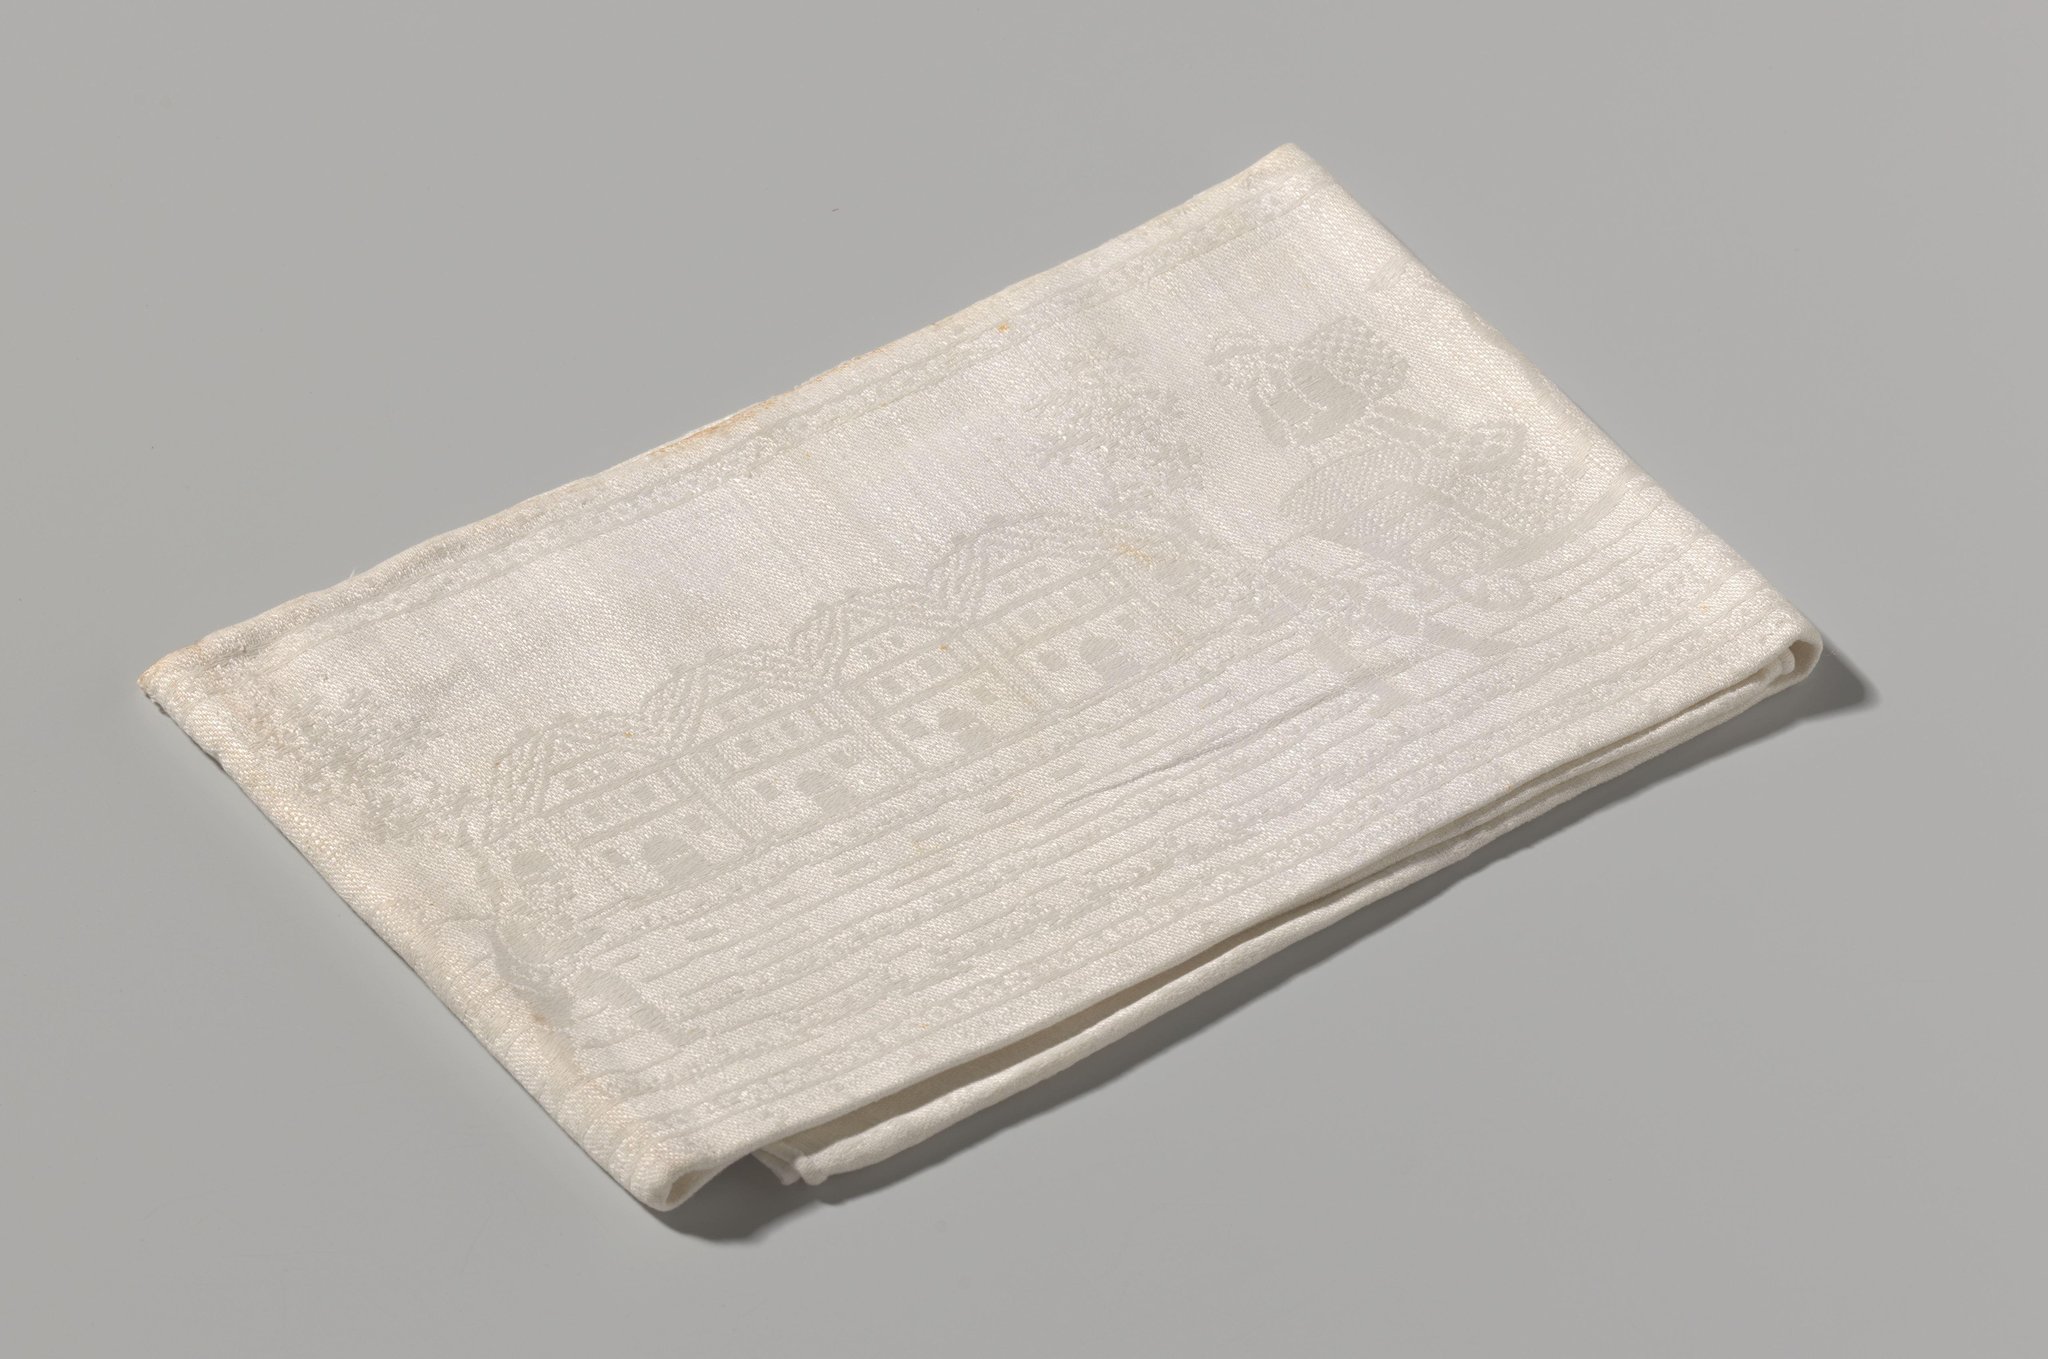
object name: napkin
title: Servet met landelijke scènes, gemerkt BdW en 24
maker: Anonymous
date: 1830-1860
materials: cotton, linen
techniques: damask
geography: germany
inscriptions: mark: ‘onleesbaar’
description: Wit halflinnen damasten servet met landelijke taferelen, gemerkt BdW en 24.